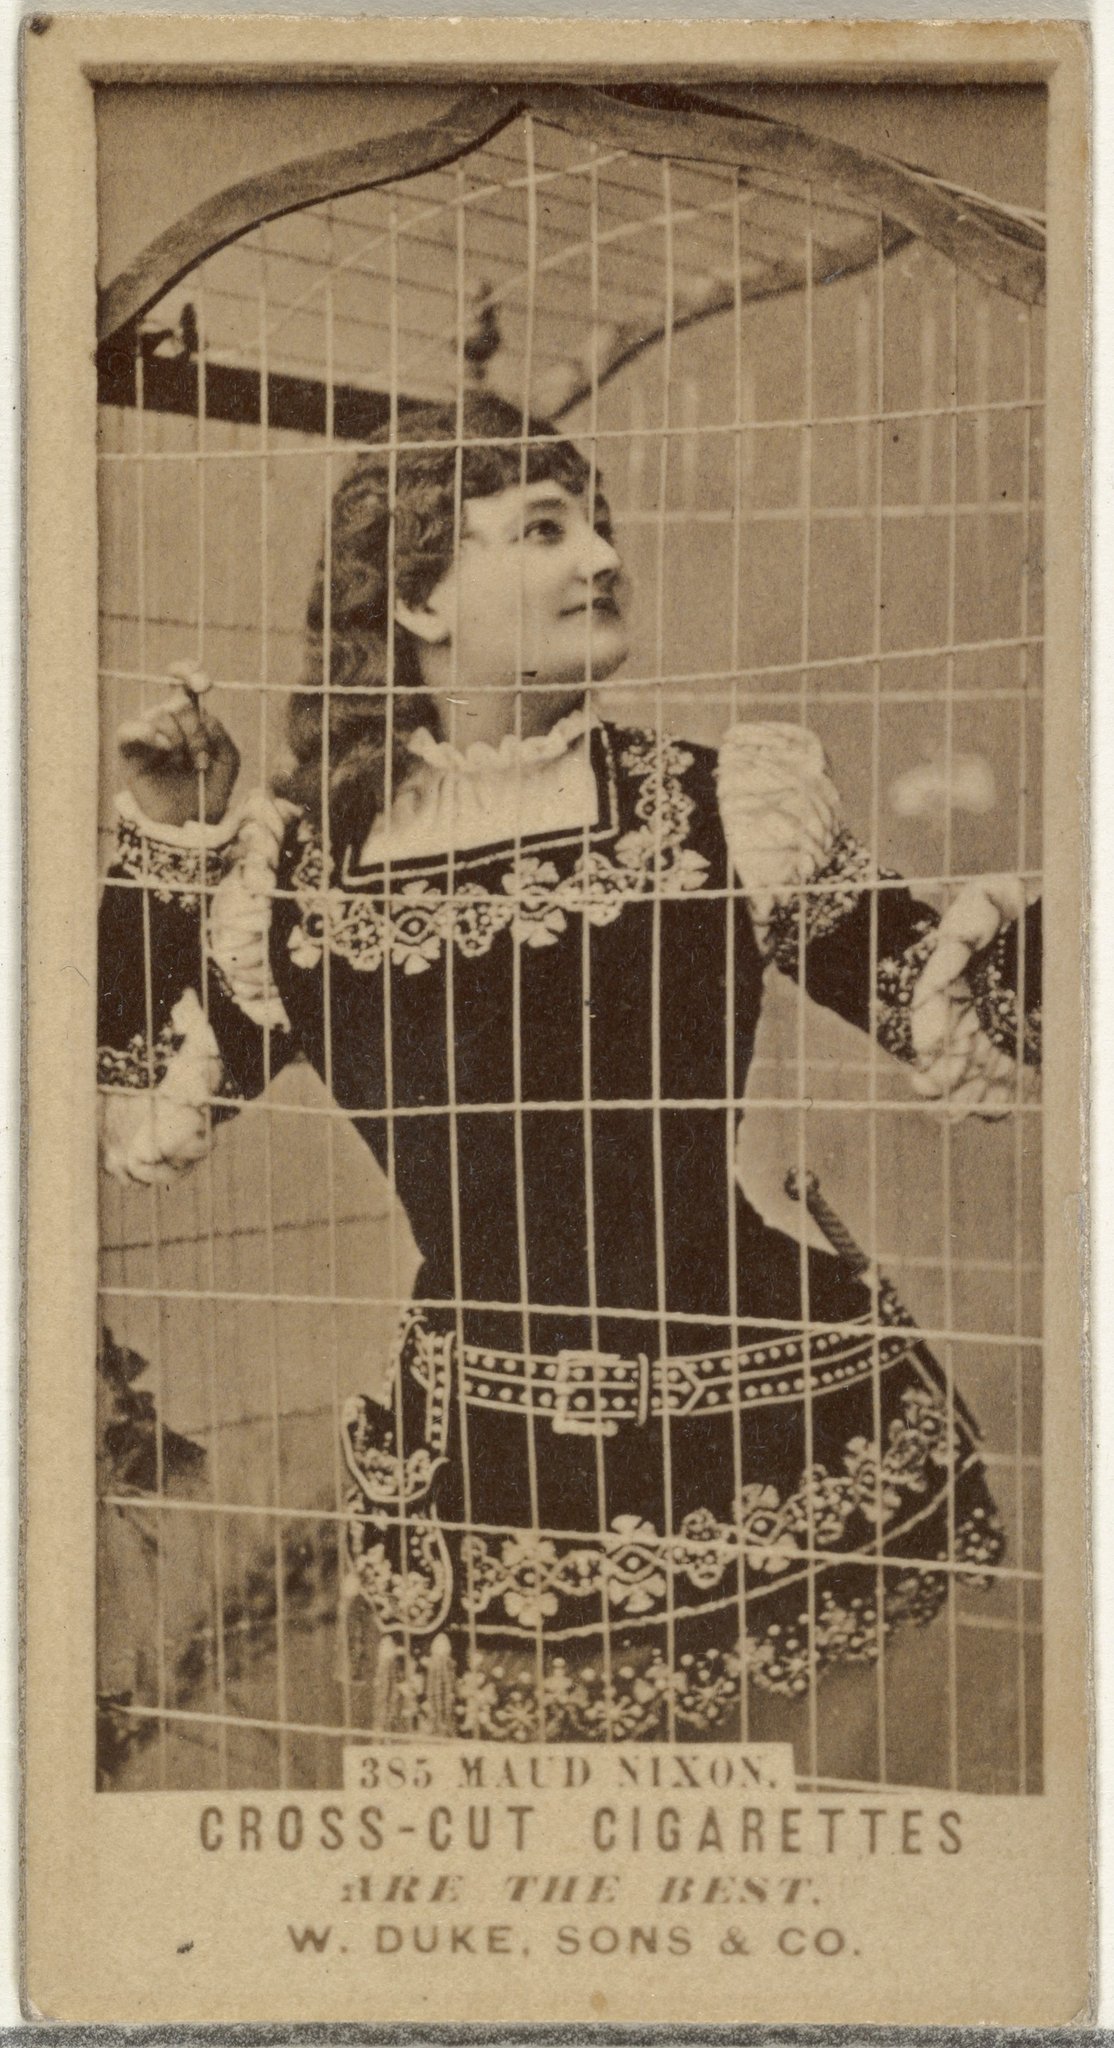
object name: photograph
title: Card Number 385, Maud Nixon, from the Actors and Actresses series (N145-3) issued by Duke Sons & Co. to promote Cross Cut Cigarettes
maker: w. duke, sons & co.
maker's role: publisher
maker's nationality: american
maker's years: 1870-1920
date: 1880-1889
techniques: albumen silver print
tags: portraits,women,actresses